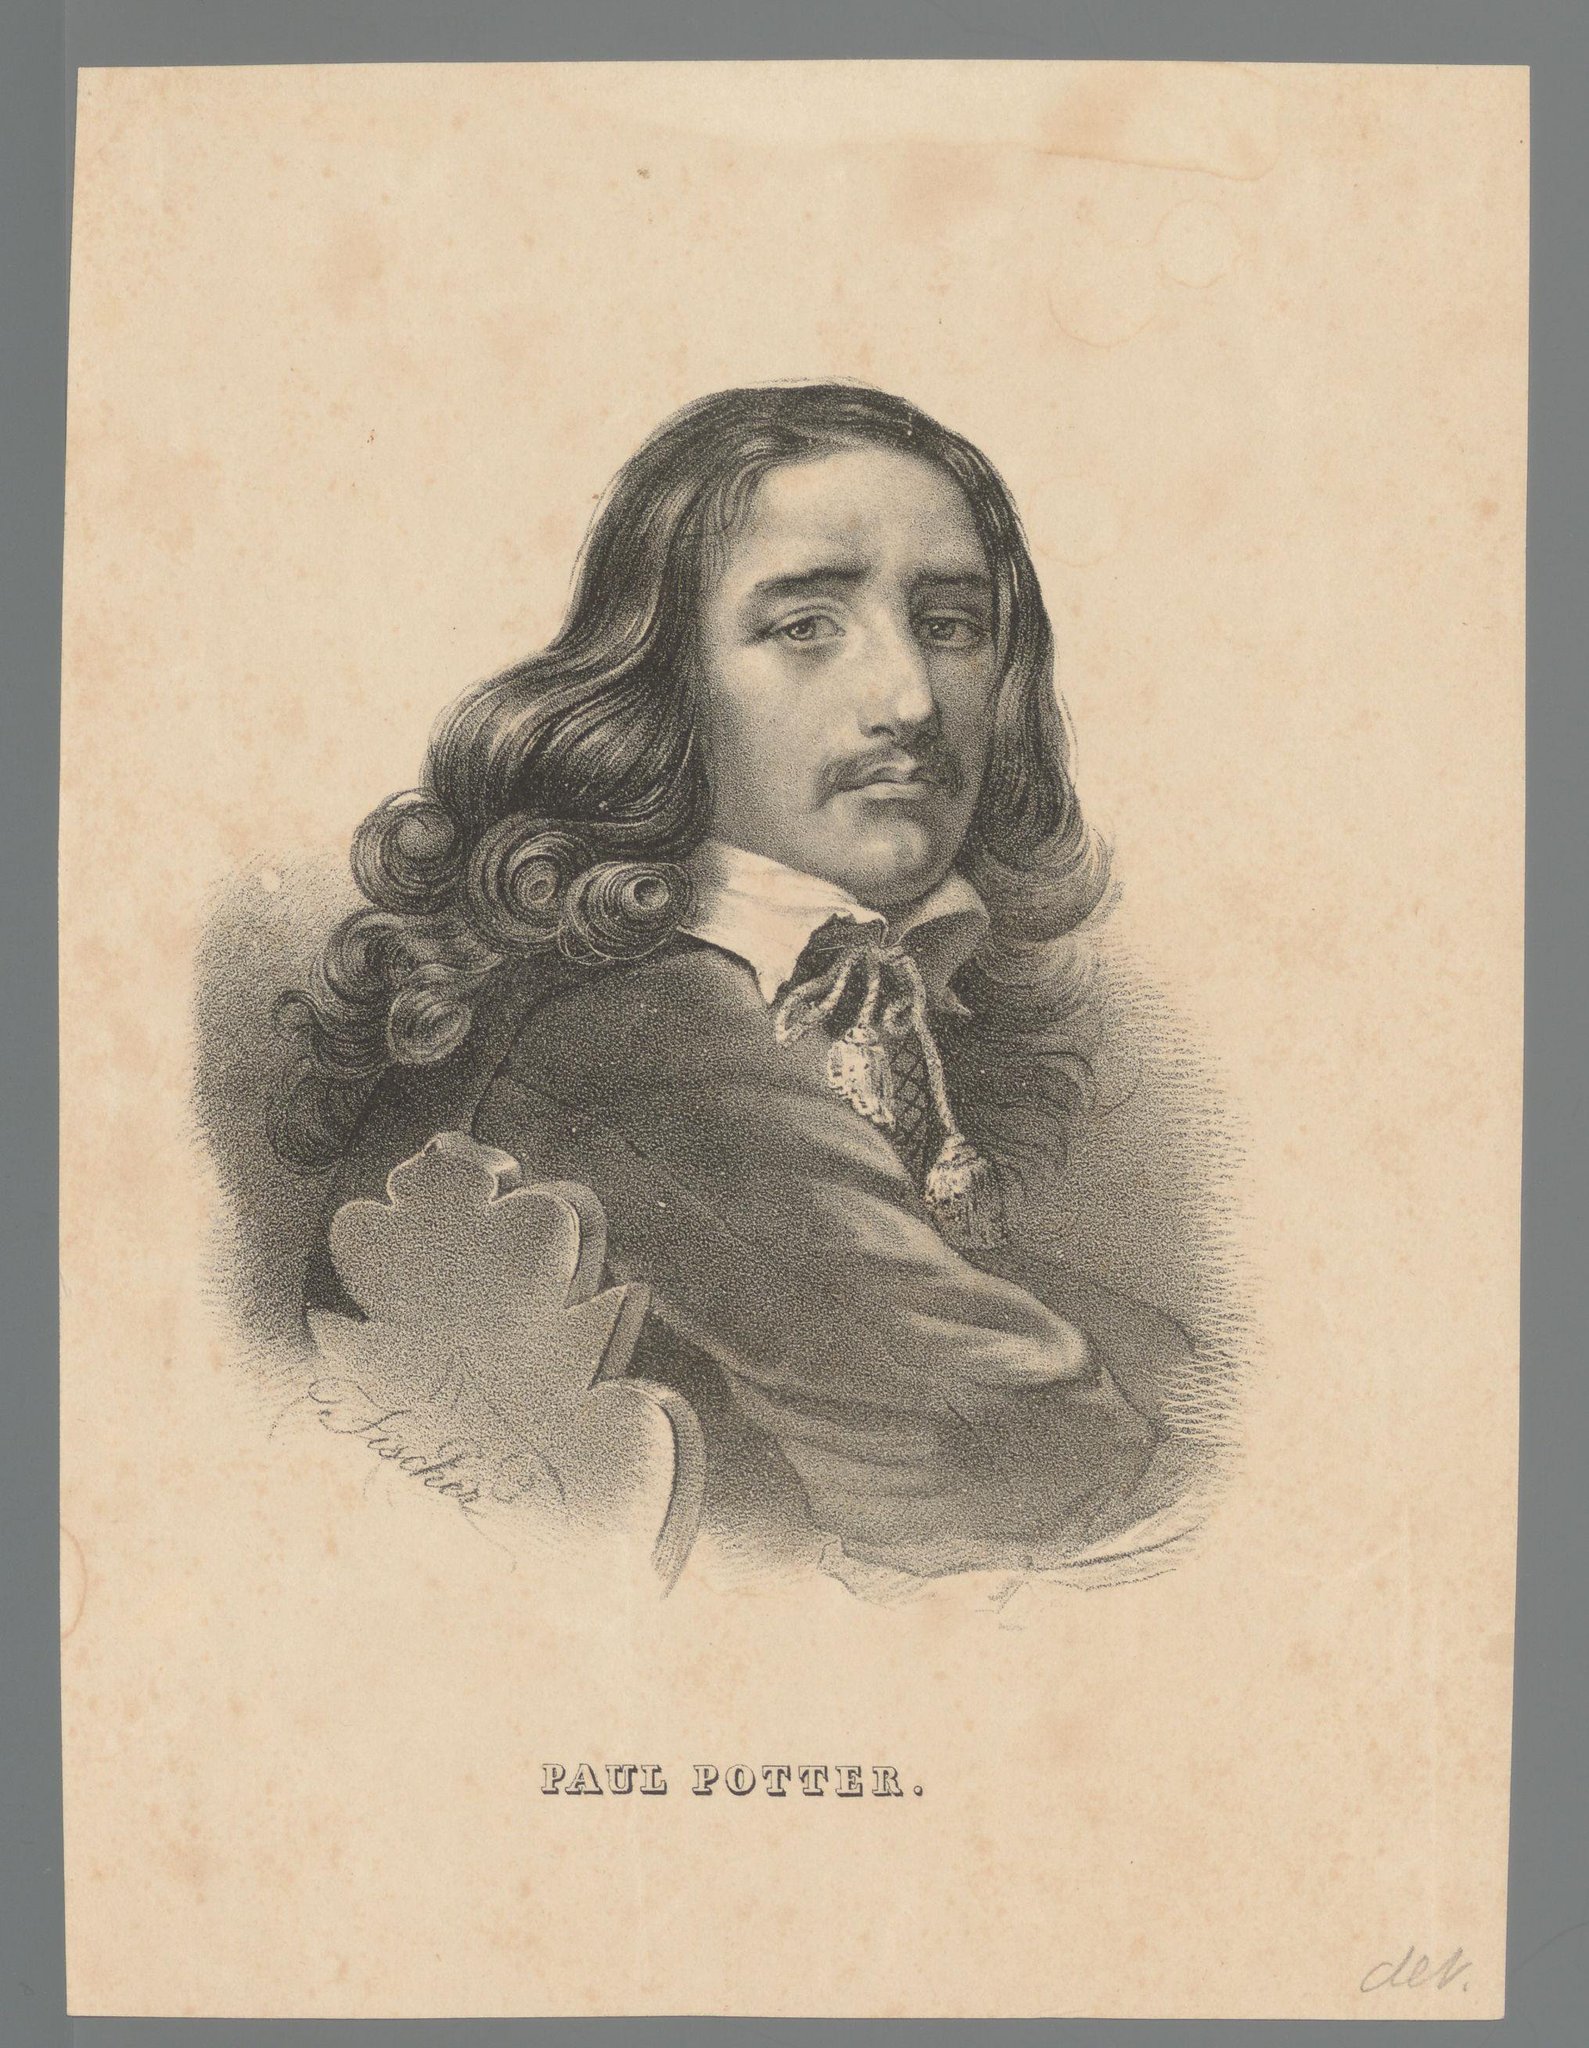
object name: print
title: Portret van Paulus Potter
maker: h. fischer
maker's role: print maker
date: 1830-1860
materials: paper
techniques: lithograph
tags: enkhuizen, amsterdam, painter, print maker, draughtsman, paulus potter, historical persons, portrait, self-portrait of painter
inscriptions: collector's mark: Lugt 2228